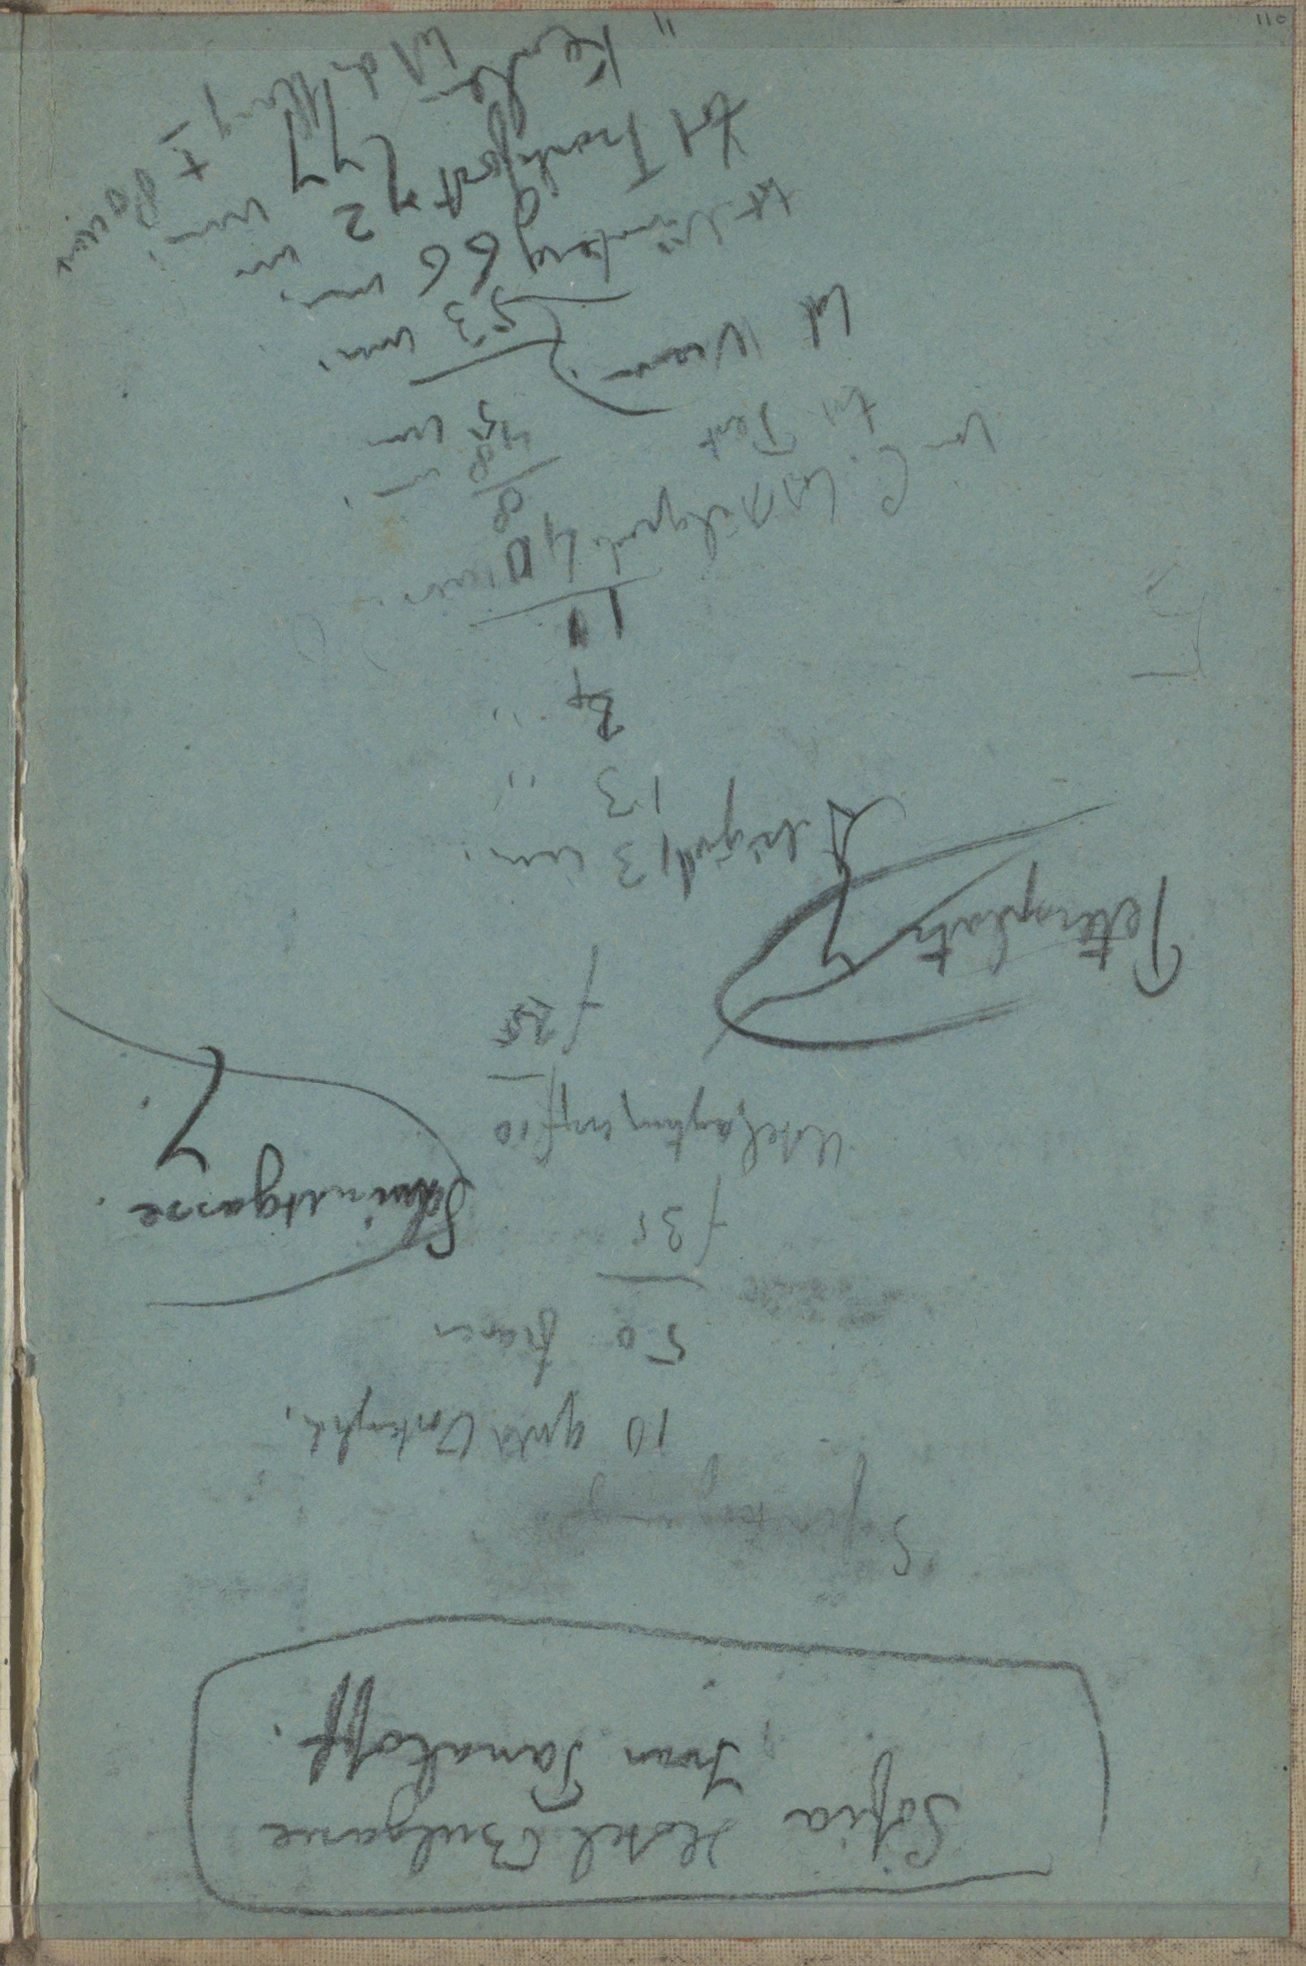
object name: sketchbook leaf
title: Reisnotities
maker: marius bauer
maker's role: draughtsman, print maker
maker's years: 1867-1932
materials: chalk, paper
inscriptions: annotation: ‘Sofia Hotel Bulgave/ Ivan Tanatoff [...]’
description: Pagina 110, schutblad, uit een schetsboek met 54 bladen.